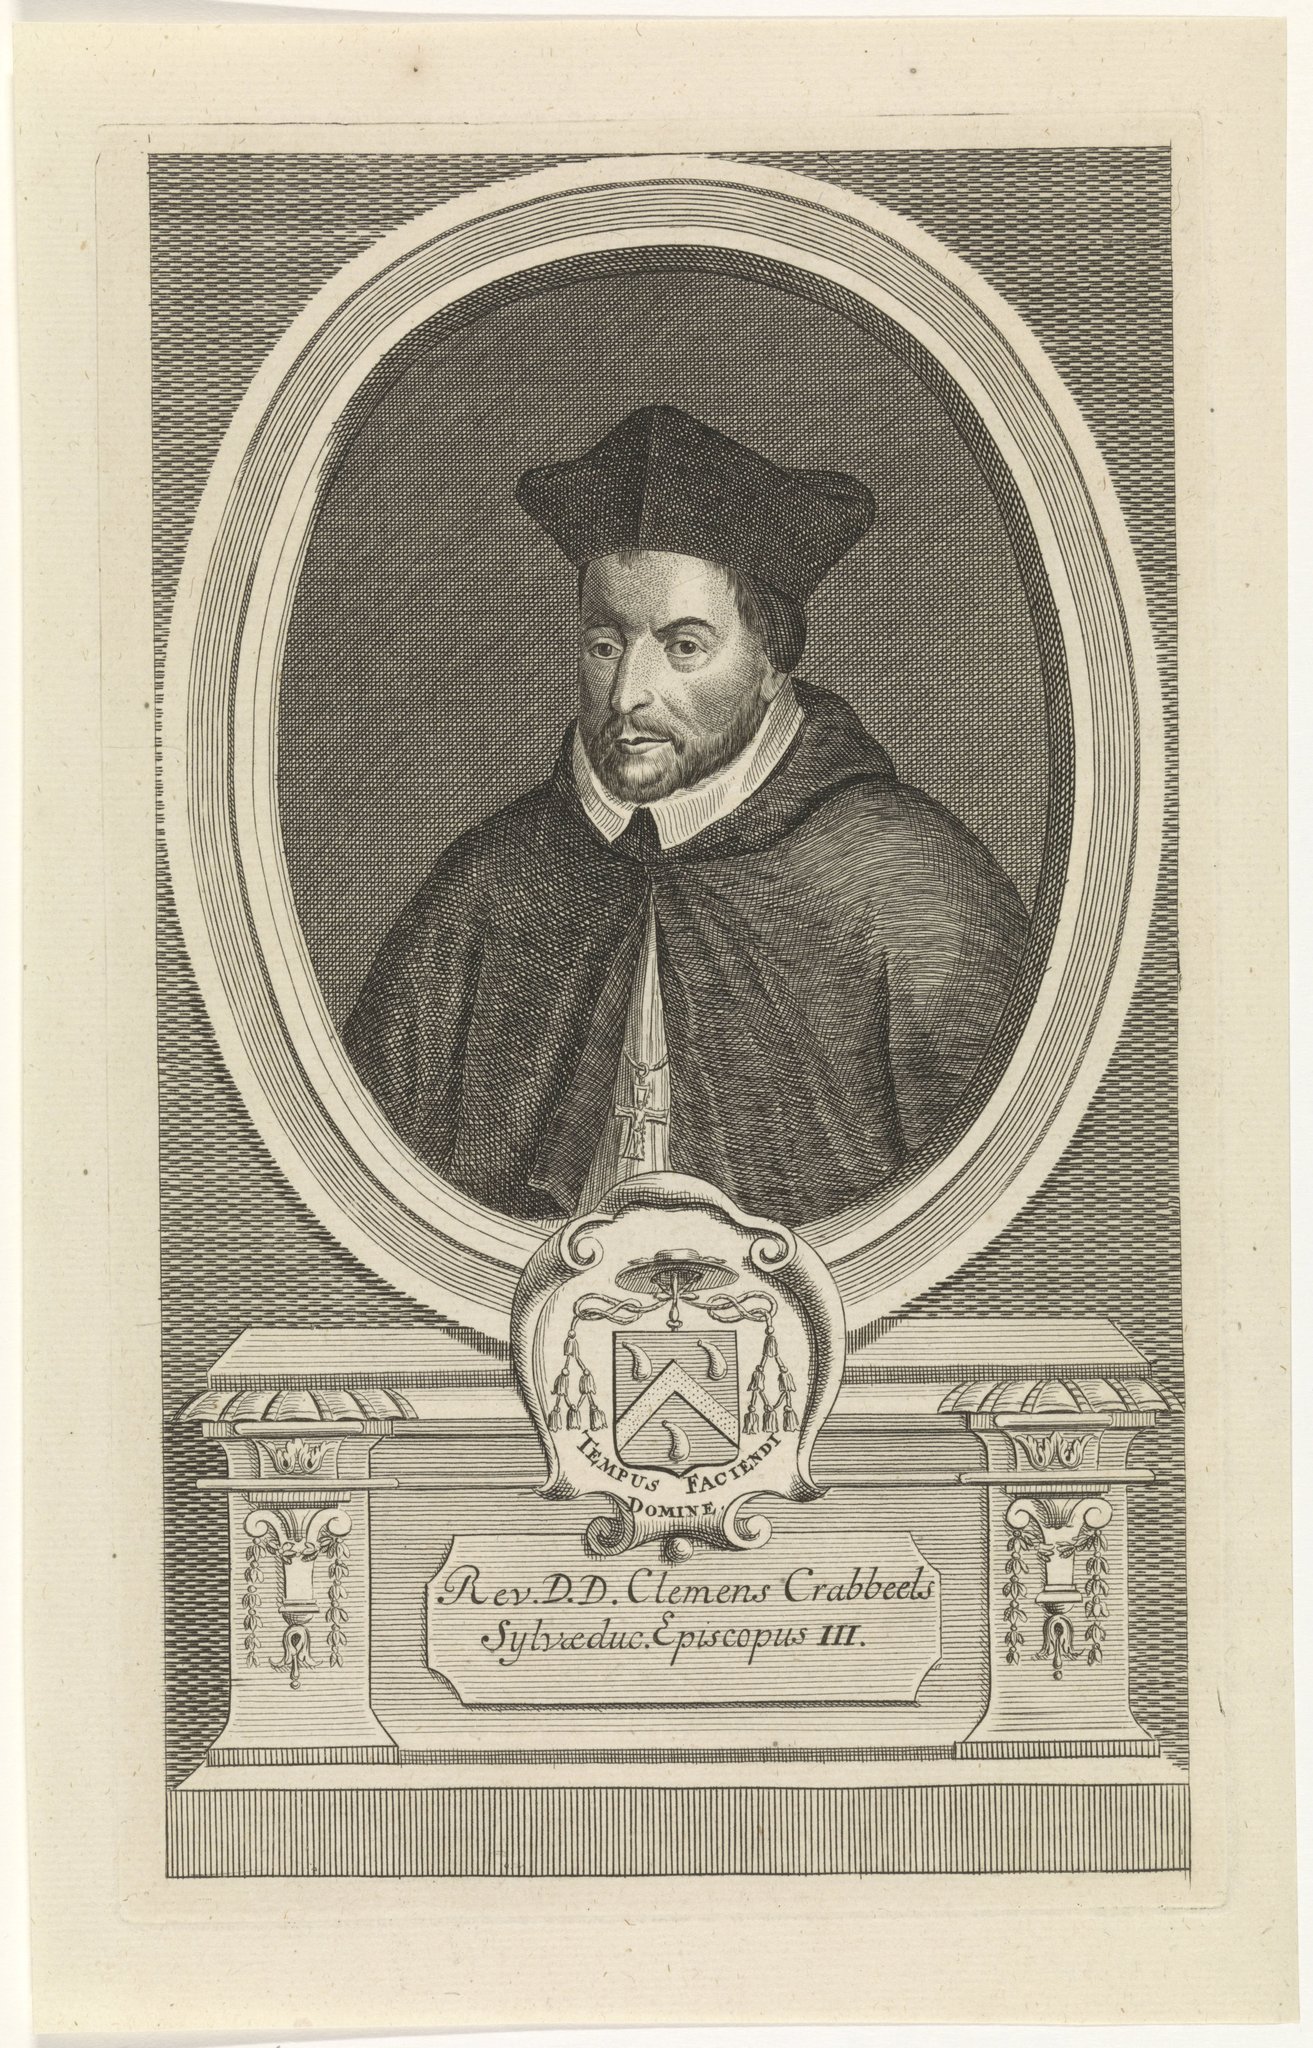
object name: print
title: Portret van Clemens Crabeels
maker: jan baptist jongelinx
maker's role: print maker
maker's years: 1689-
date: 1710-1725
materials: paper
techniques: engraving, etching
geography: antwerp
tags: den bosch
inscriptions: collector's mark: Lugt 2228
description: Busteportret van de bisschop Clemens Crabeels, met biretta. Het portret is gevat in een ovale omlijsting met het wapenschild van de geportretteerde en een motto in het Latijn. In een kader een tweeregelig onderschrift in het Latijn.